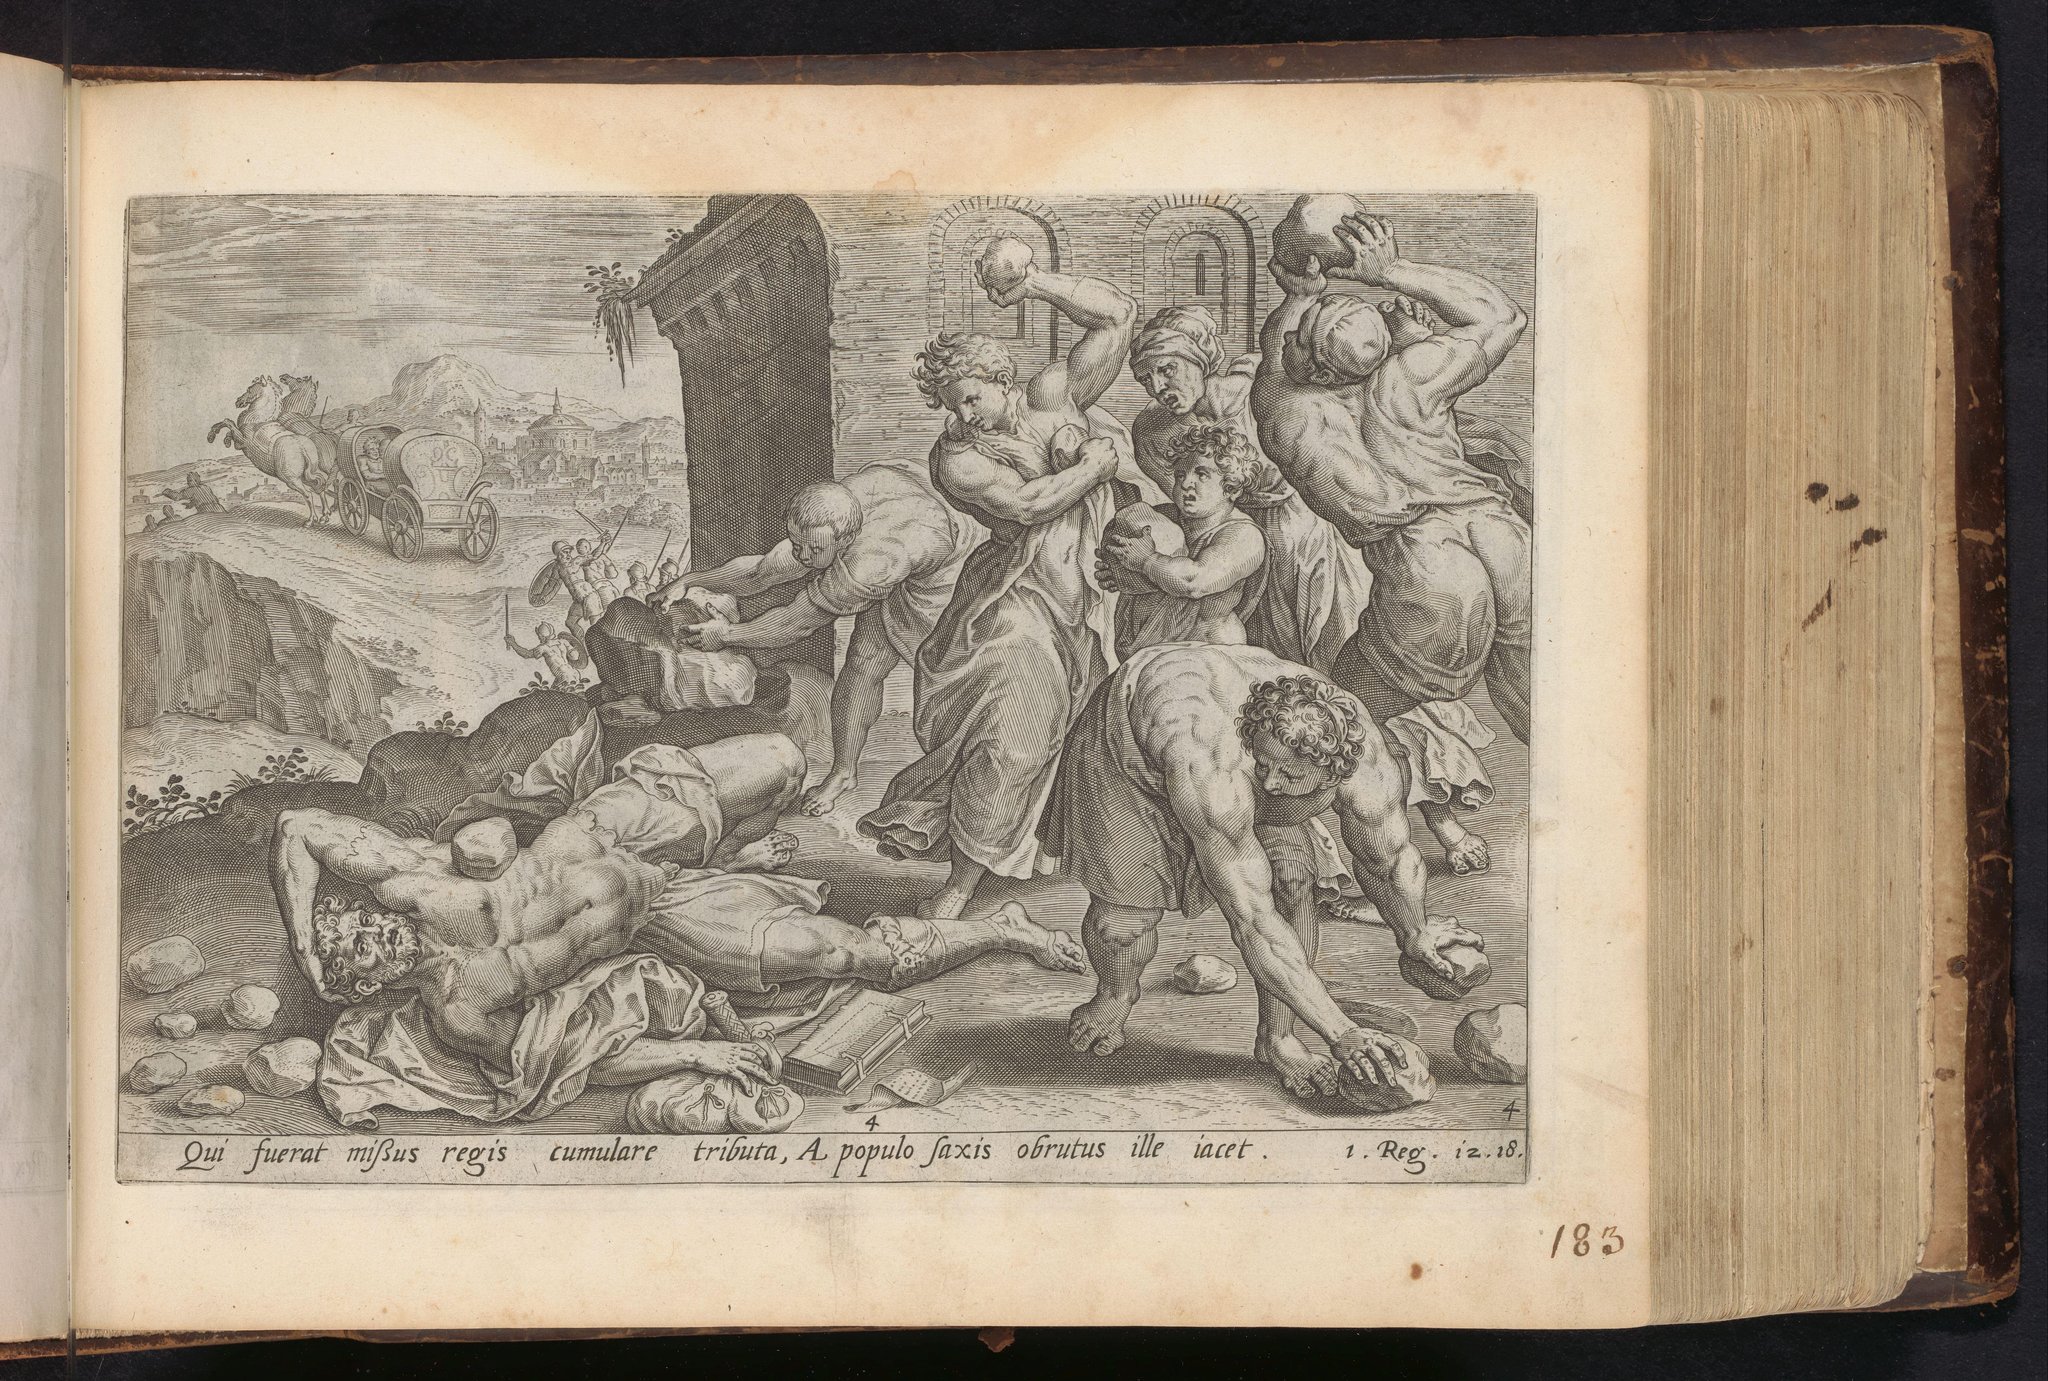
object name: print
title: Den Grooten Figuer-Bibel (...)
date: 1579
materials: paper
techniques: engraving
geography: alkmaar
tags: purse, money-bag, adoram is stoned to death; rehoboam escapes in his chariot to jerusalem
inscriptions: number: ‘183’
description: Koning Rechabeam stuurde Adoniram, zijn opzichter van de herendienst, naar de opstandige Israëlieten. De mensen stenigen Adoniram, die zijn hand houdt op een stokbeurs, die hij vermoedelijk wilde gebruiken bij het innen van de belastingen. Op de achtergrond ontsnapt koning Rechabeam in zijn koets naar Jeruzalem. Onder de voorstelling een verwijzing in het Latijn naar de Bijbeltekst in 1 Kon. 12:18. Deze prent maakt deel uit van een album.